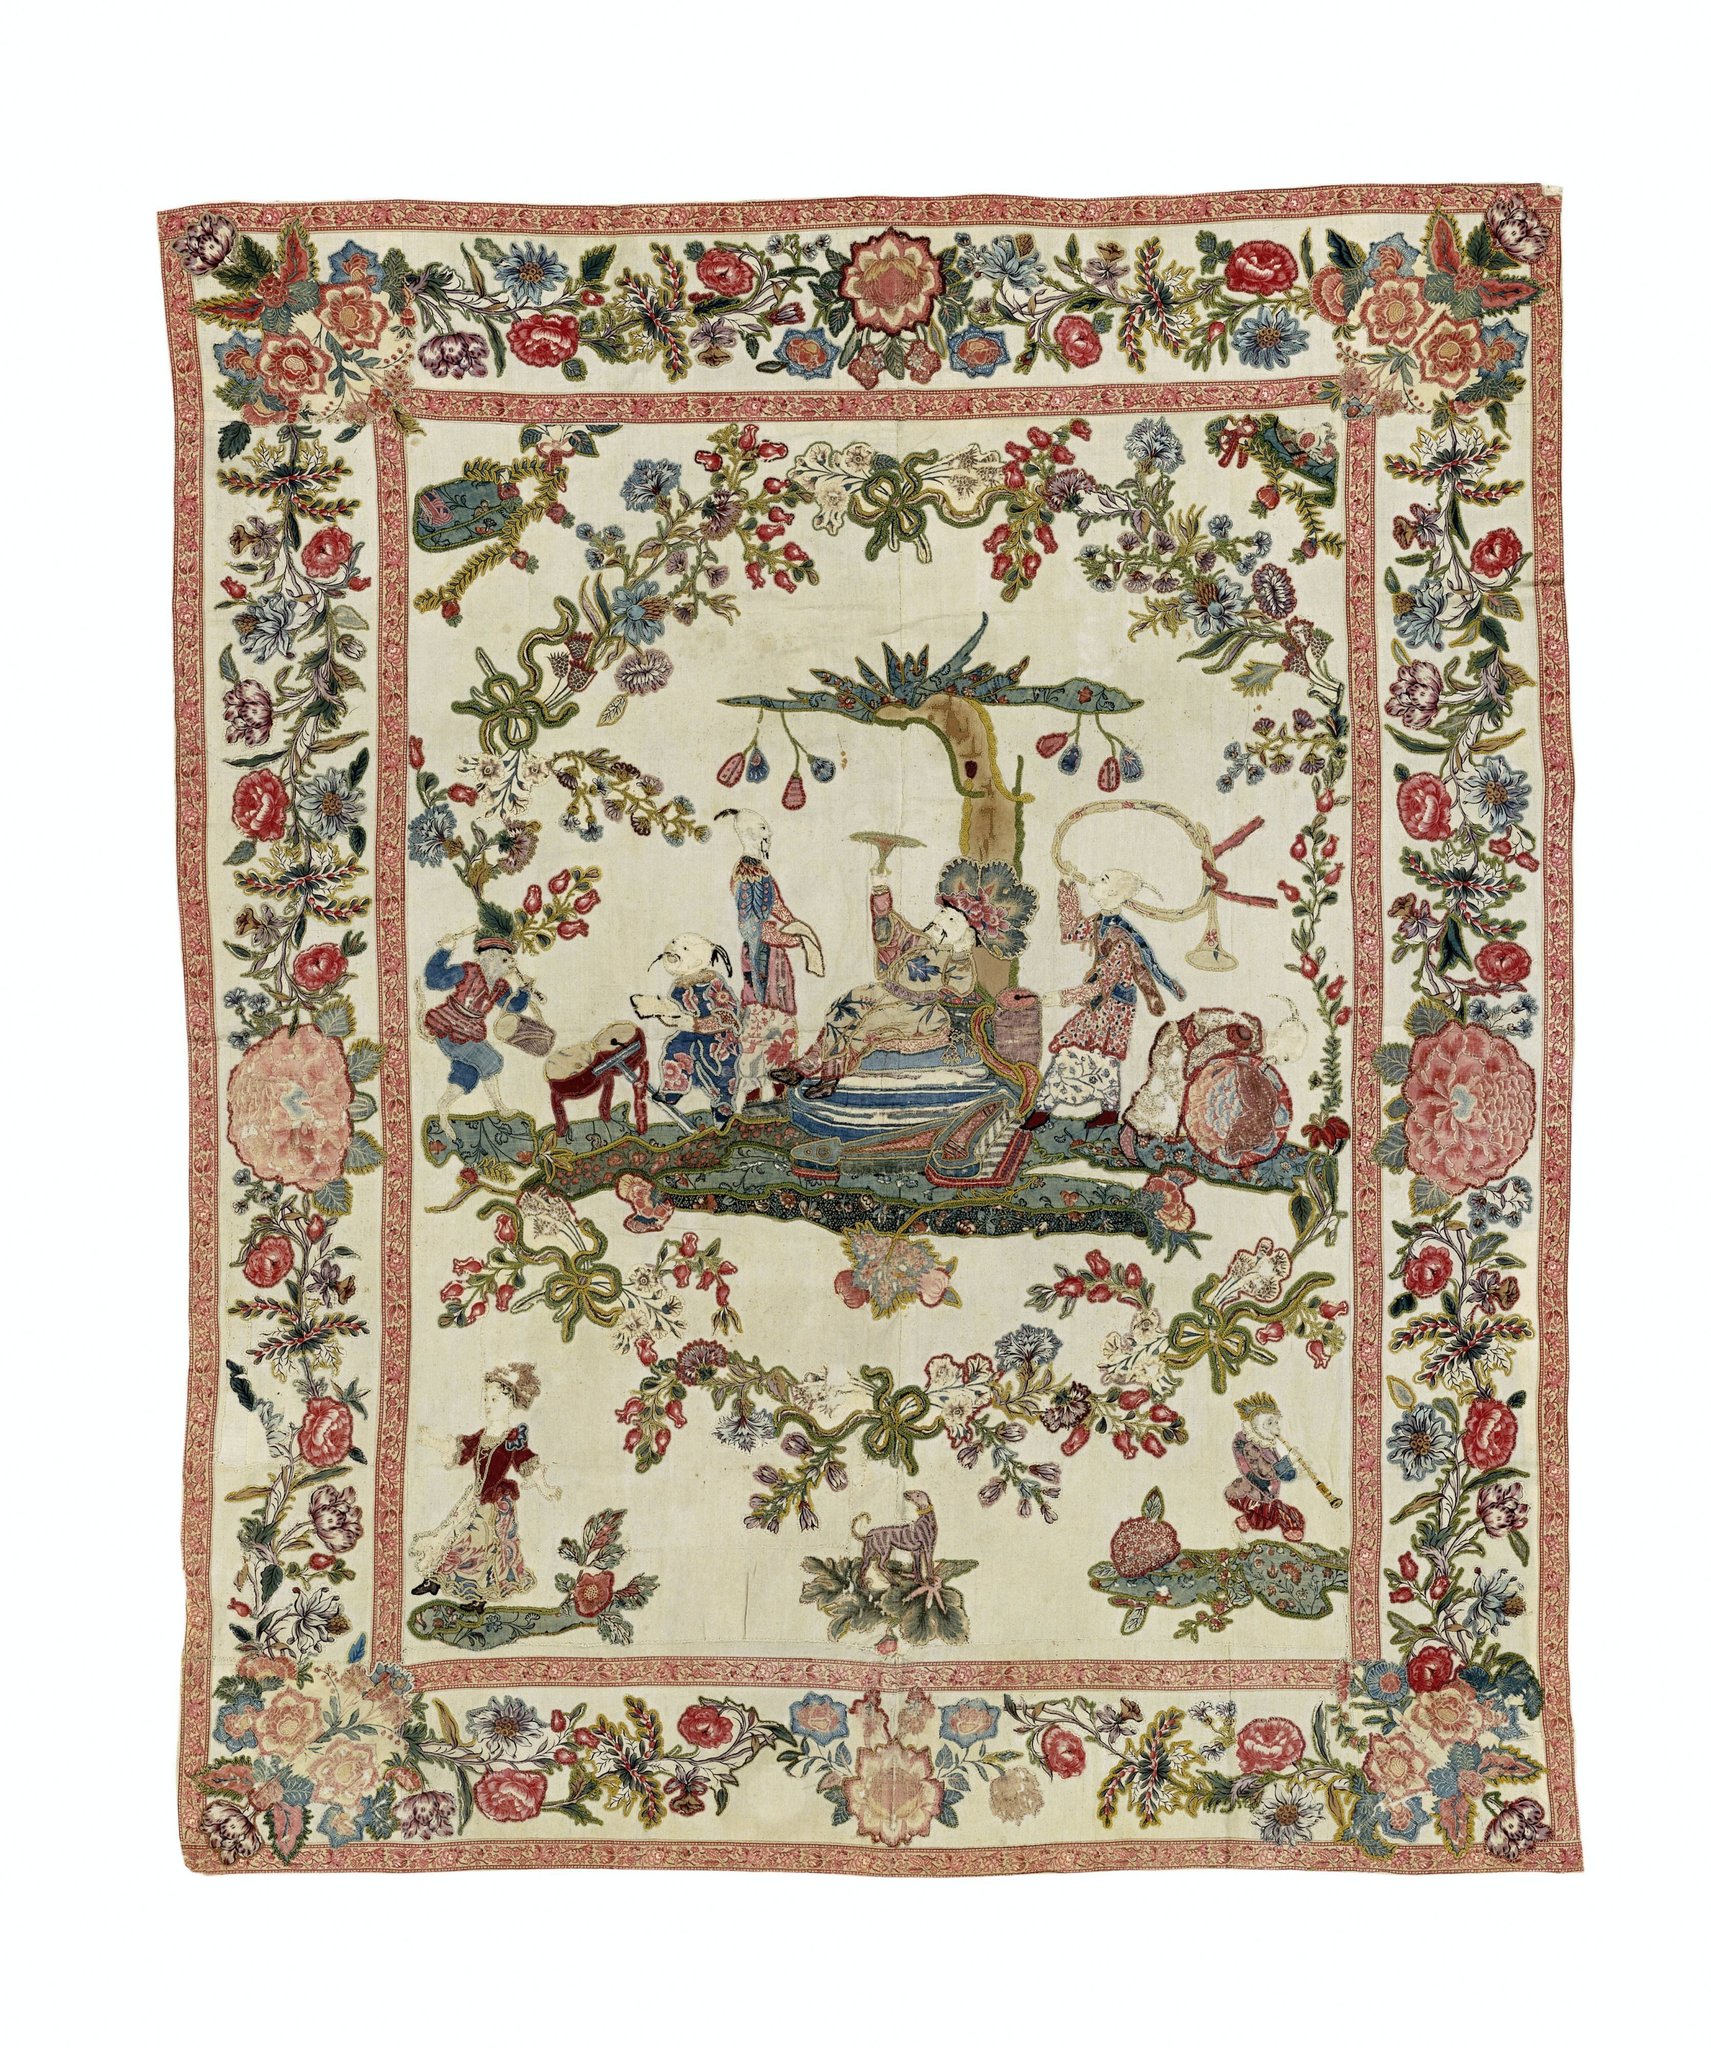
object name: bedspread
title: Bed Cover with Chinoiserie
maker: Anonymous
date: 1700-1750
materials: textile, linen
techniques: appliqué, printing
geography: europe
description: This cover is decorated with Chinese scenes. The emperor of China sits under a tree in the central field, encircled by a floral wreath with bows: a typically European design. He drinks wine and listens to music played by his servants and monkeys. The border of the cover is embellished with appliqué work, decorative pieces of fabric sewn on top. Similar chinoiserie also features in lacquerware and embroidery.